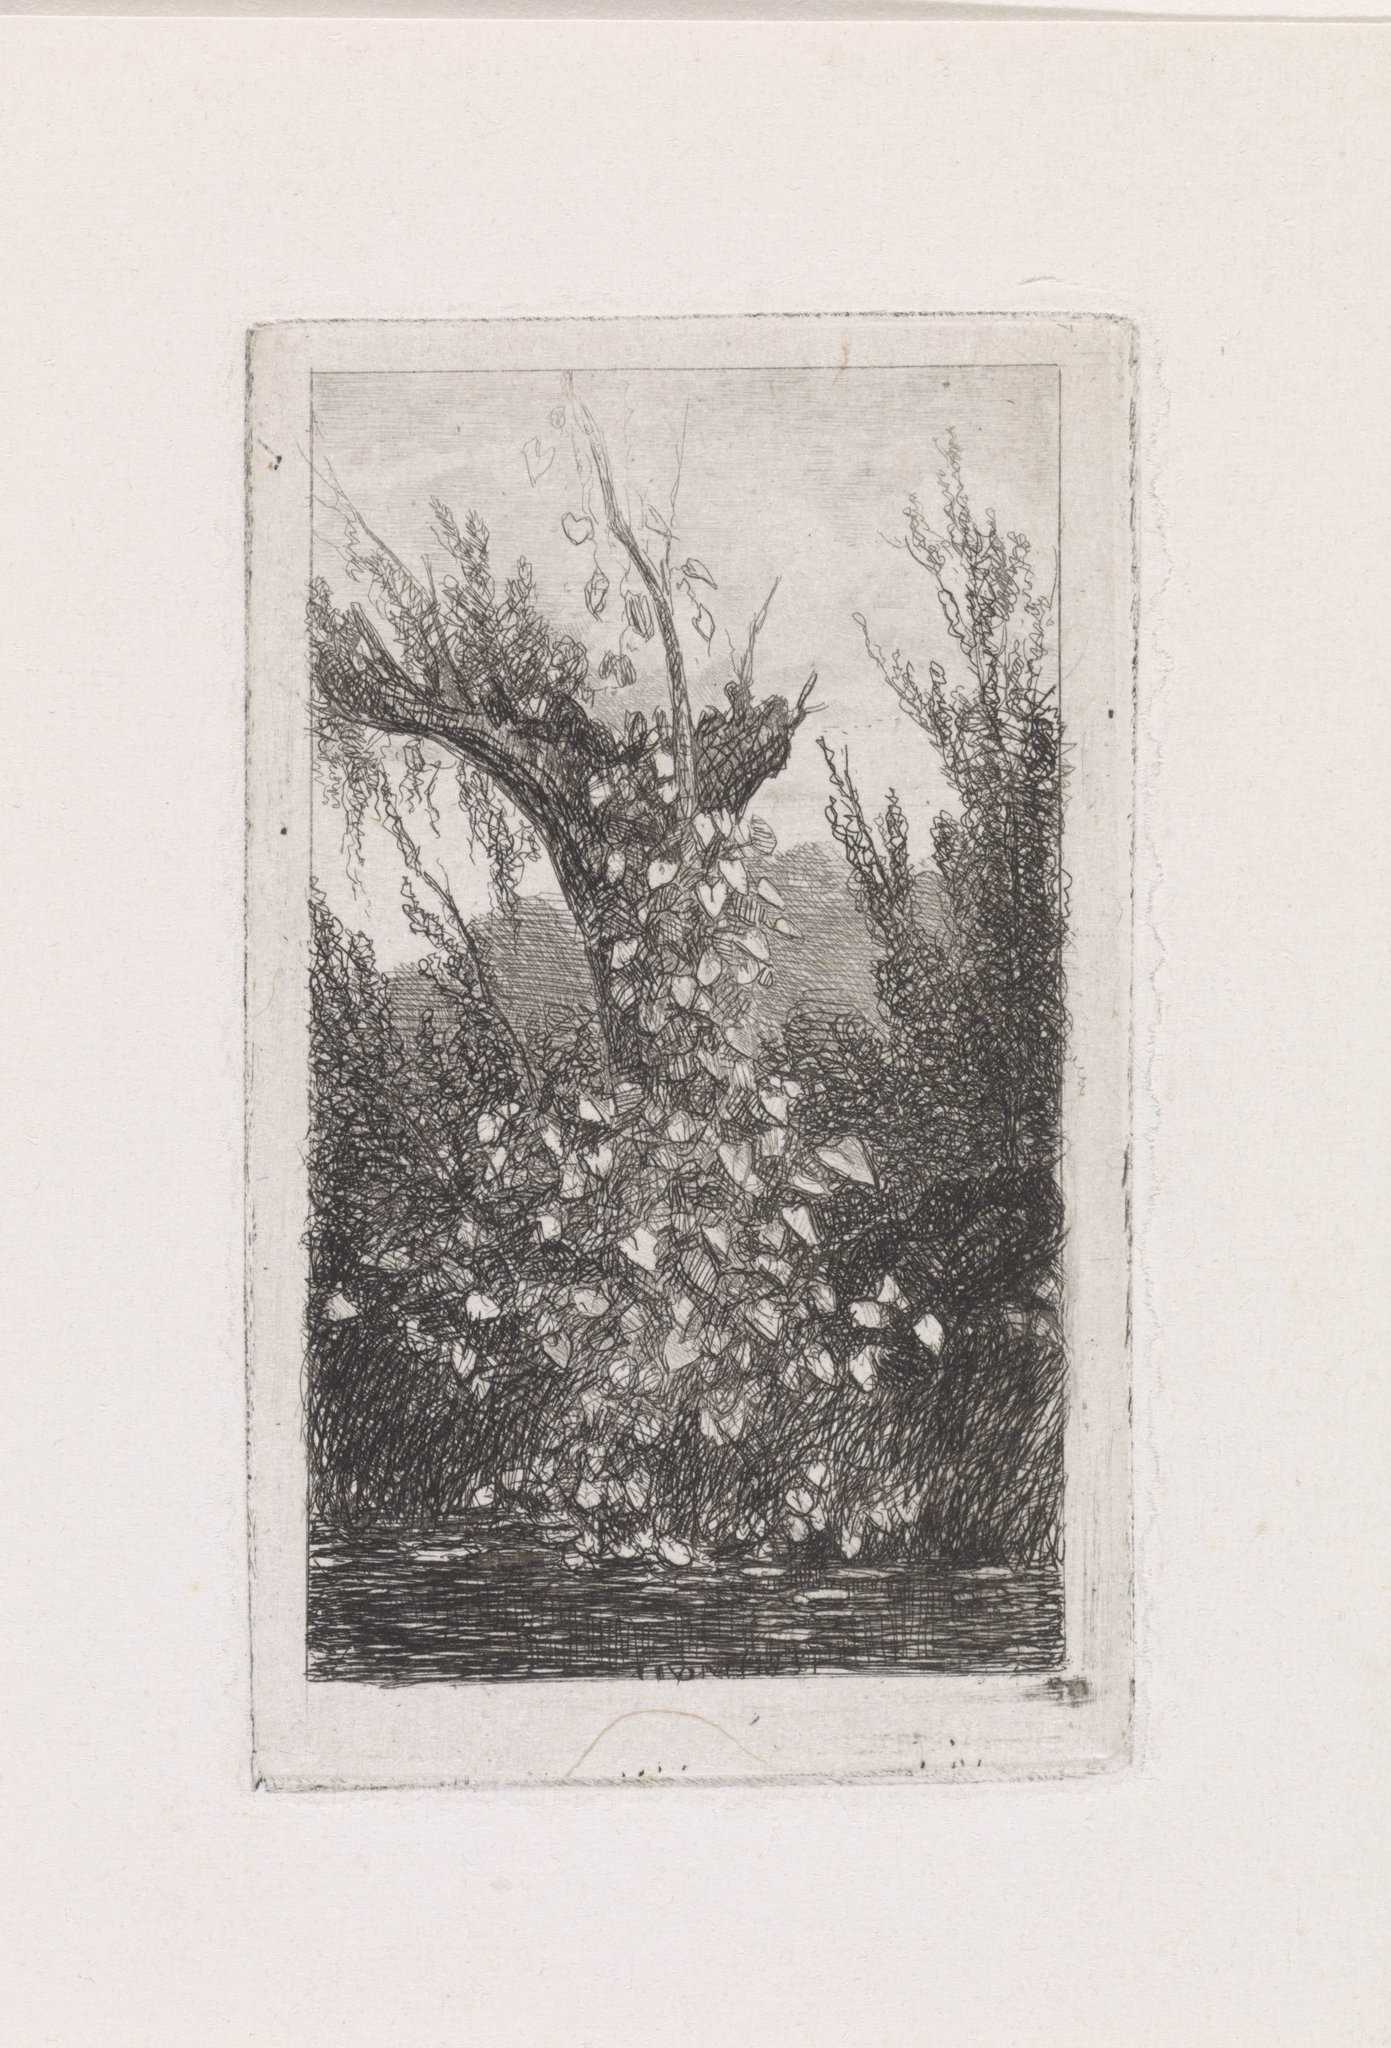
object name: print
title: Begroeide knotwilg aan een waterkant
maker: jacob jan van der maaten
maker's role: draughtsman, print maker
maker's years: 1820-1879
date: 1830-1879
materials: paper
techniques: etching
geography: netherlands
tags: trees (+ stem, trunk)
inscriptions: collector's mark: Lugt 2228